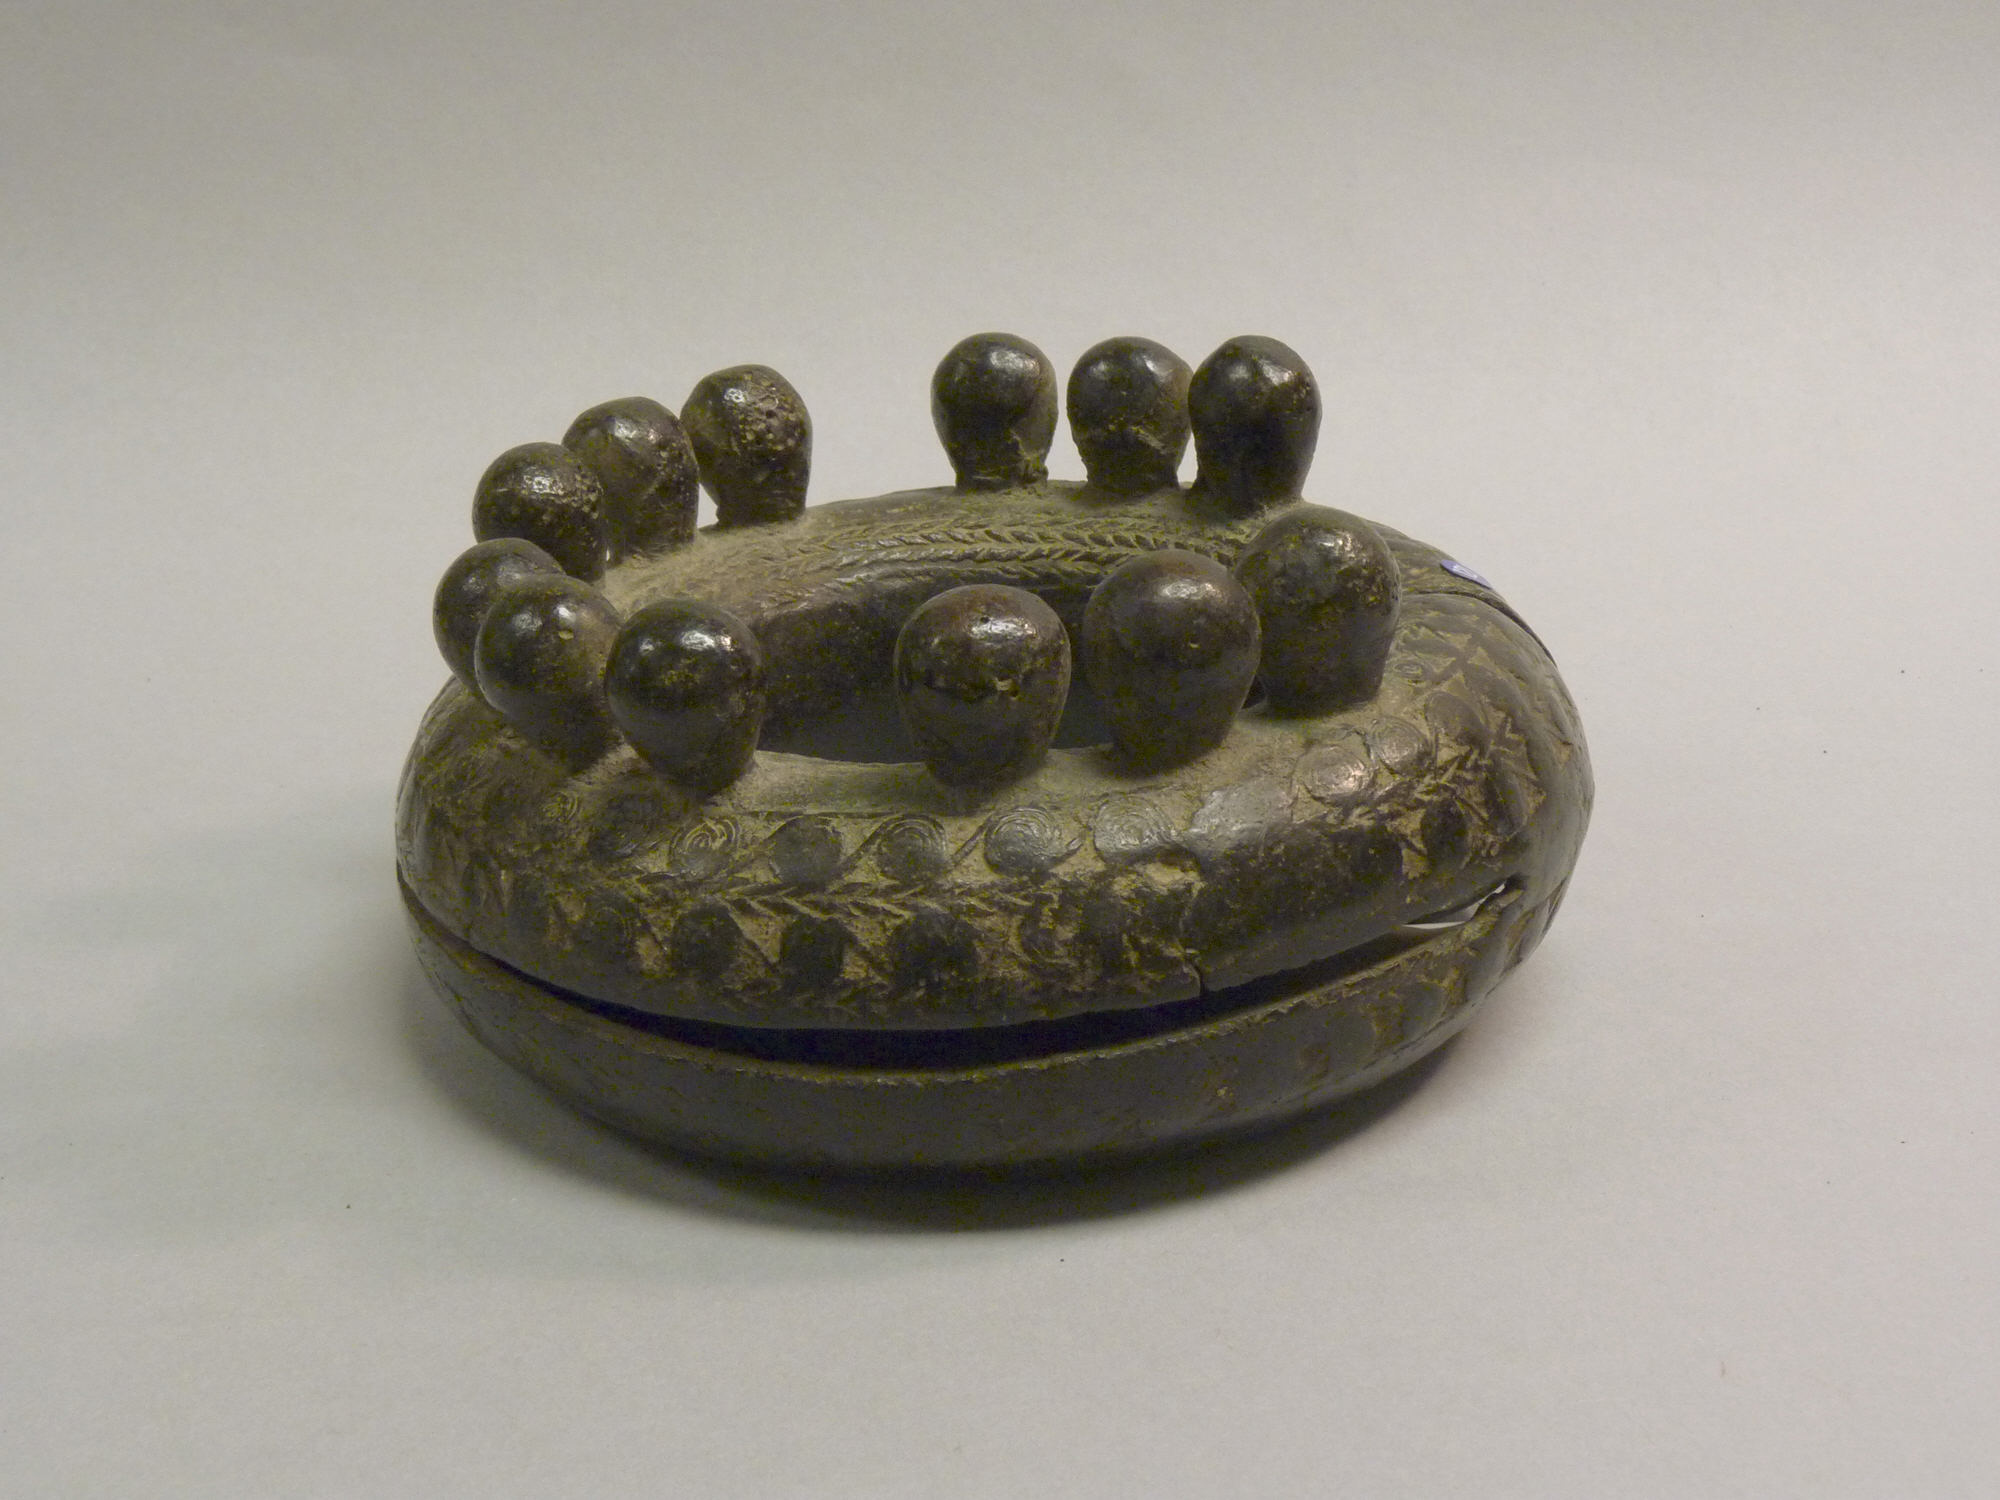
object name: anklet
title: Anklet with Spheres on Top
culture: vietnamese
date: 500 BCE-300 CE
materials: bronze